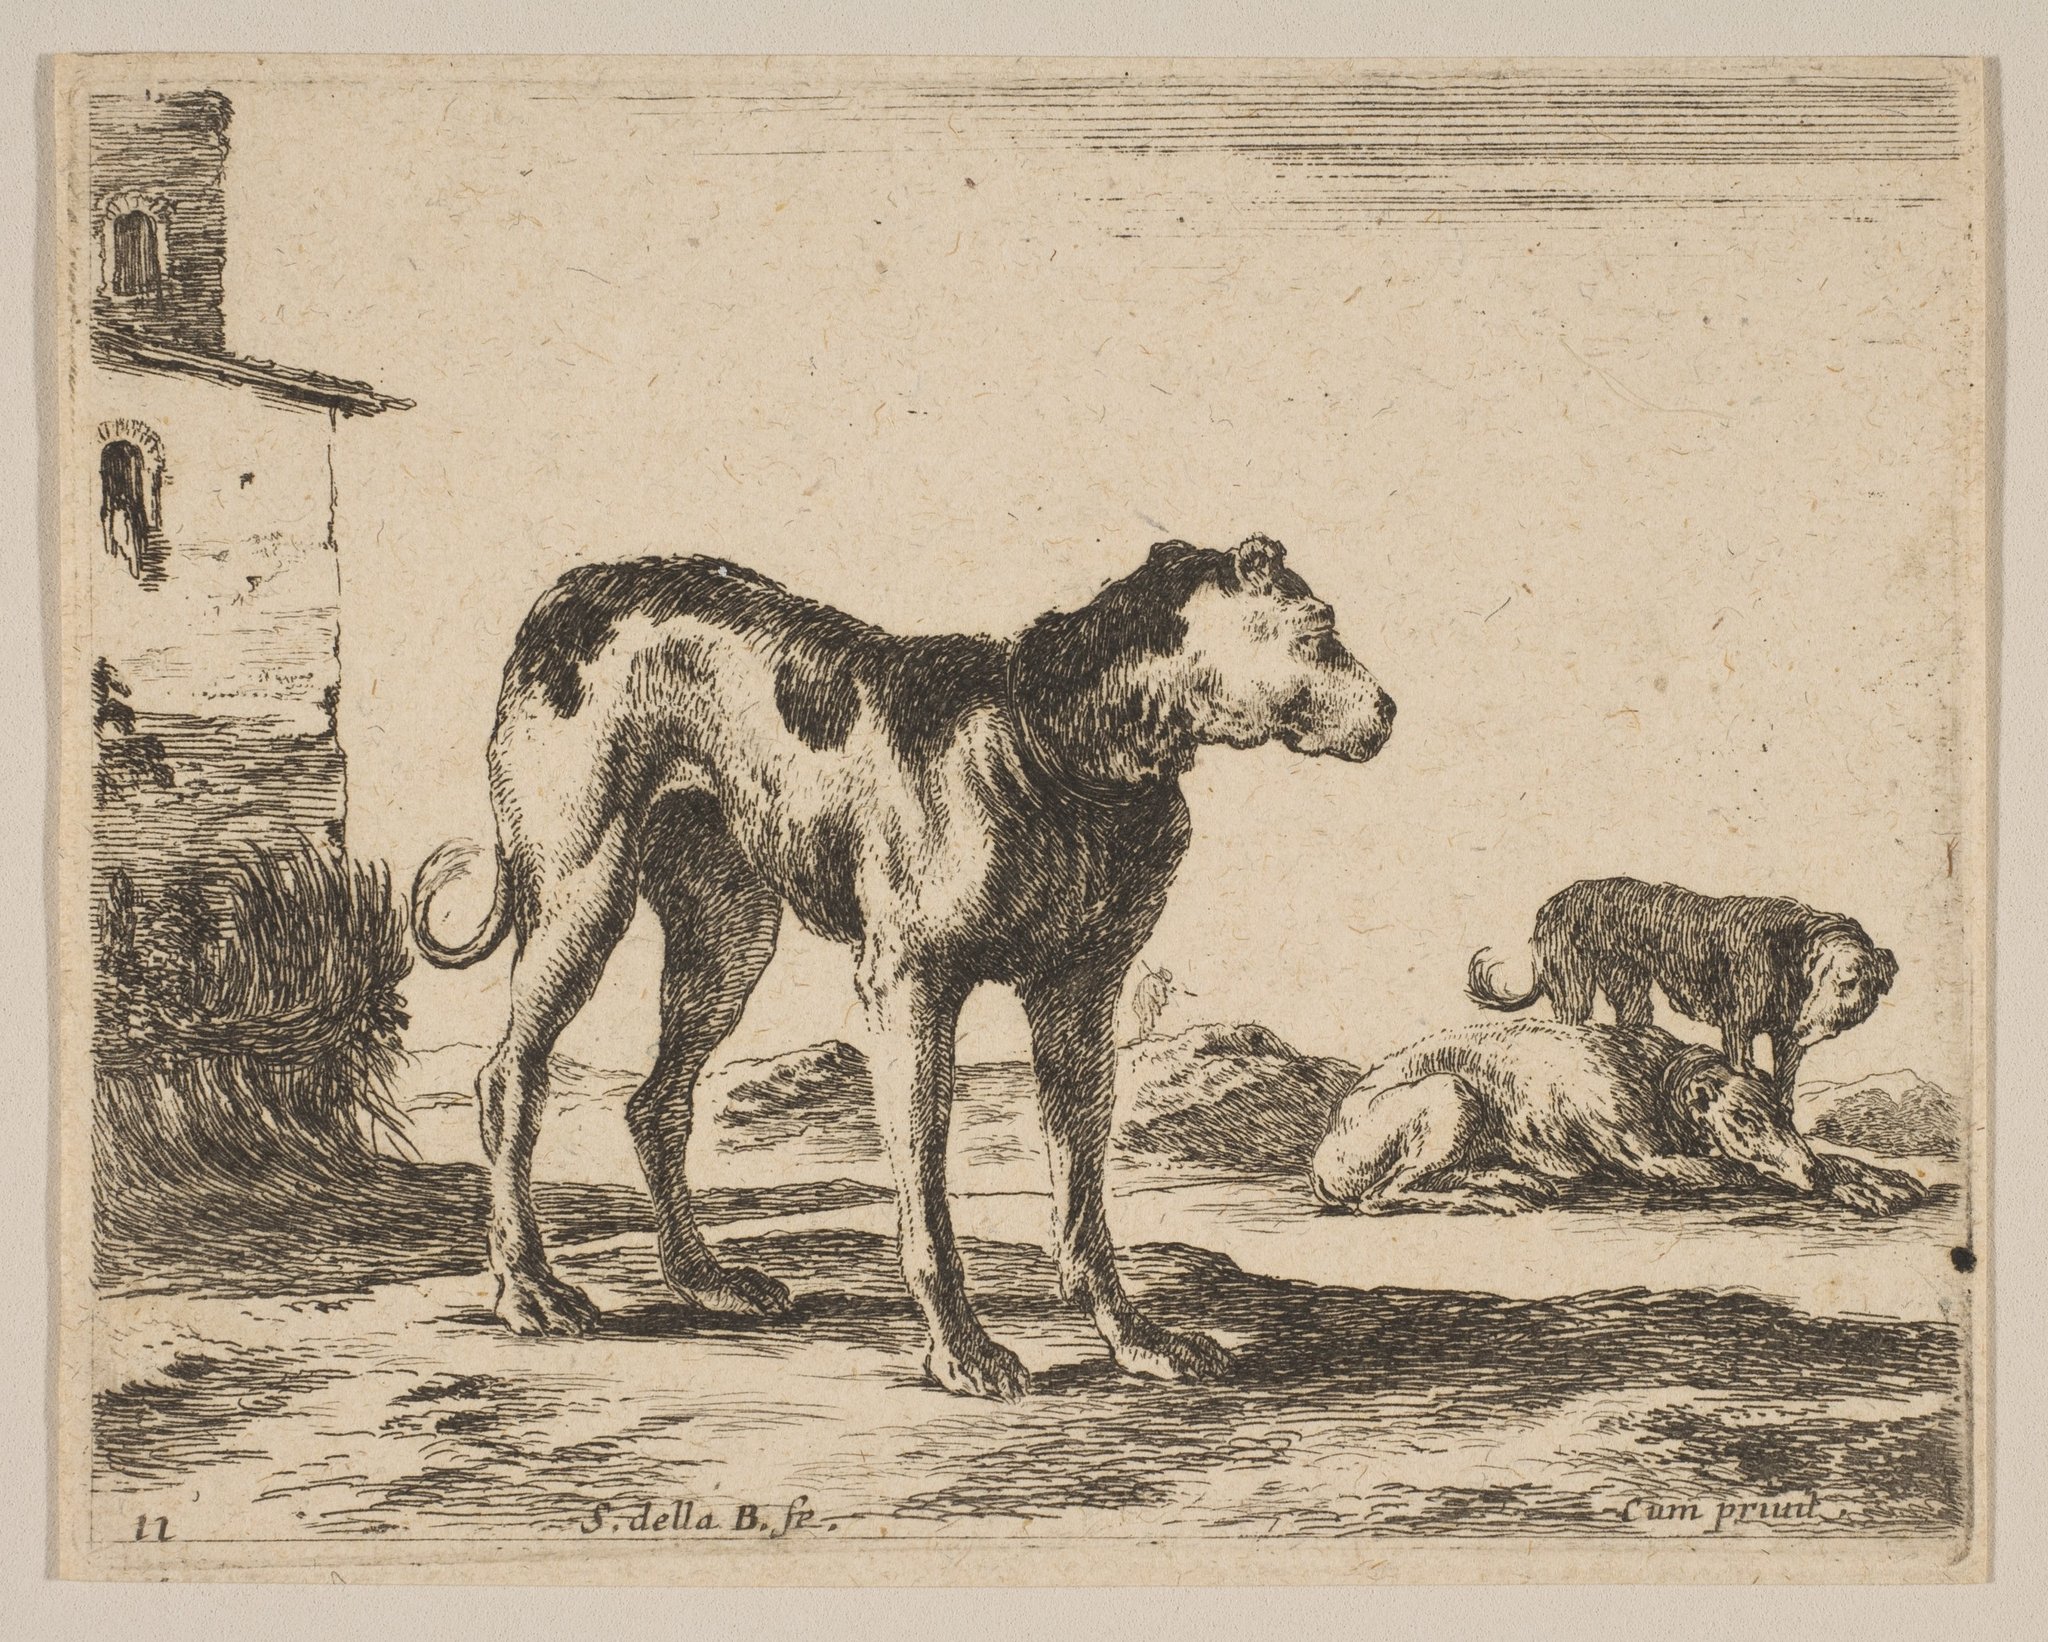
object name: print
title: Plate 11: Dogs, from "Various animals" (Diversi animali)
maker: stefano della bella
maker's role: artist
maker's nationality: italian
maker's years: 1610-1664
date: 1641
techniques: etching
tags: dogs